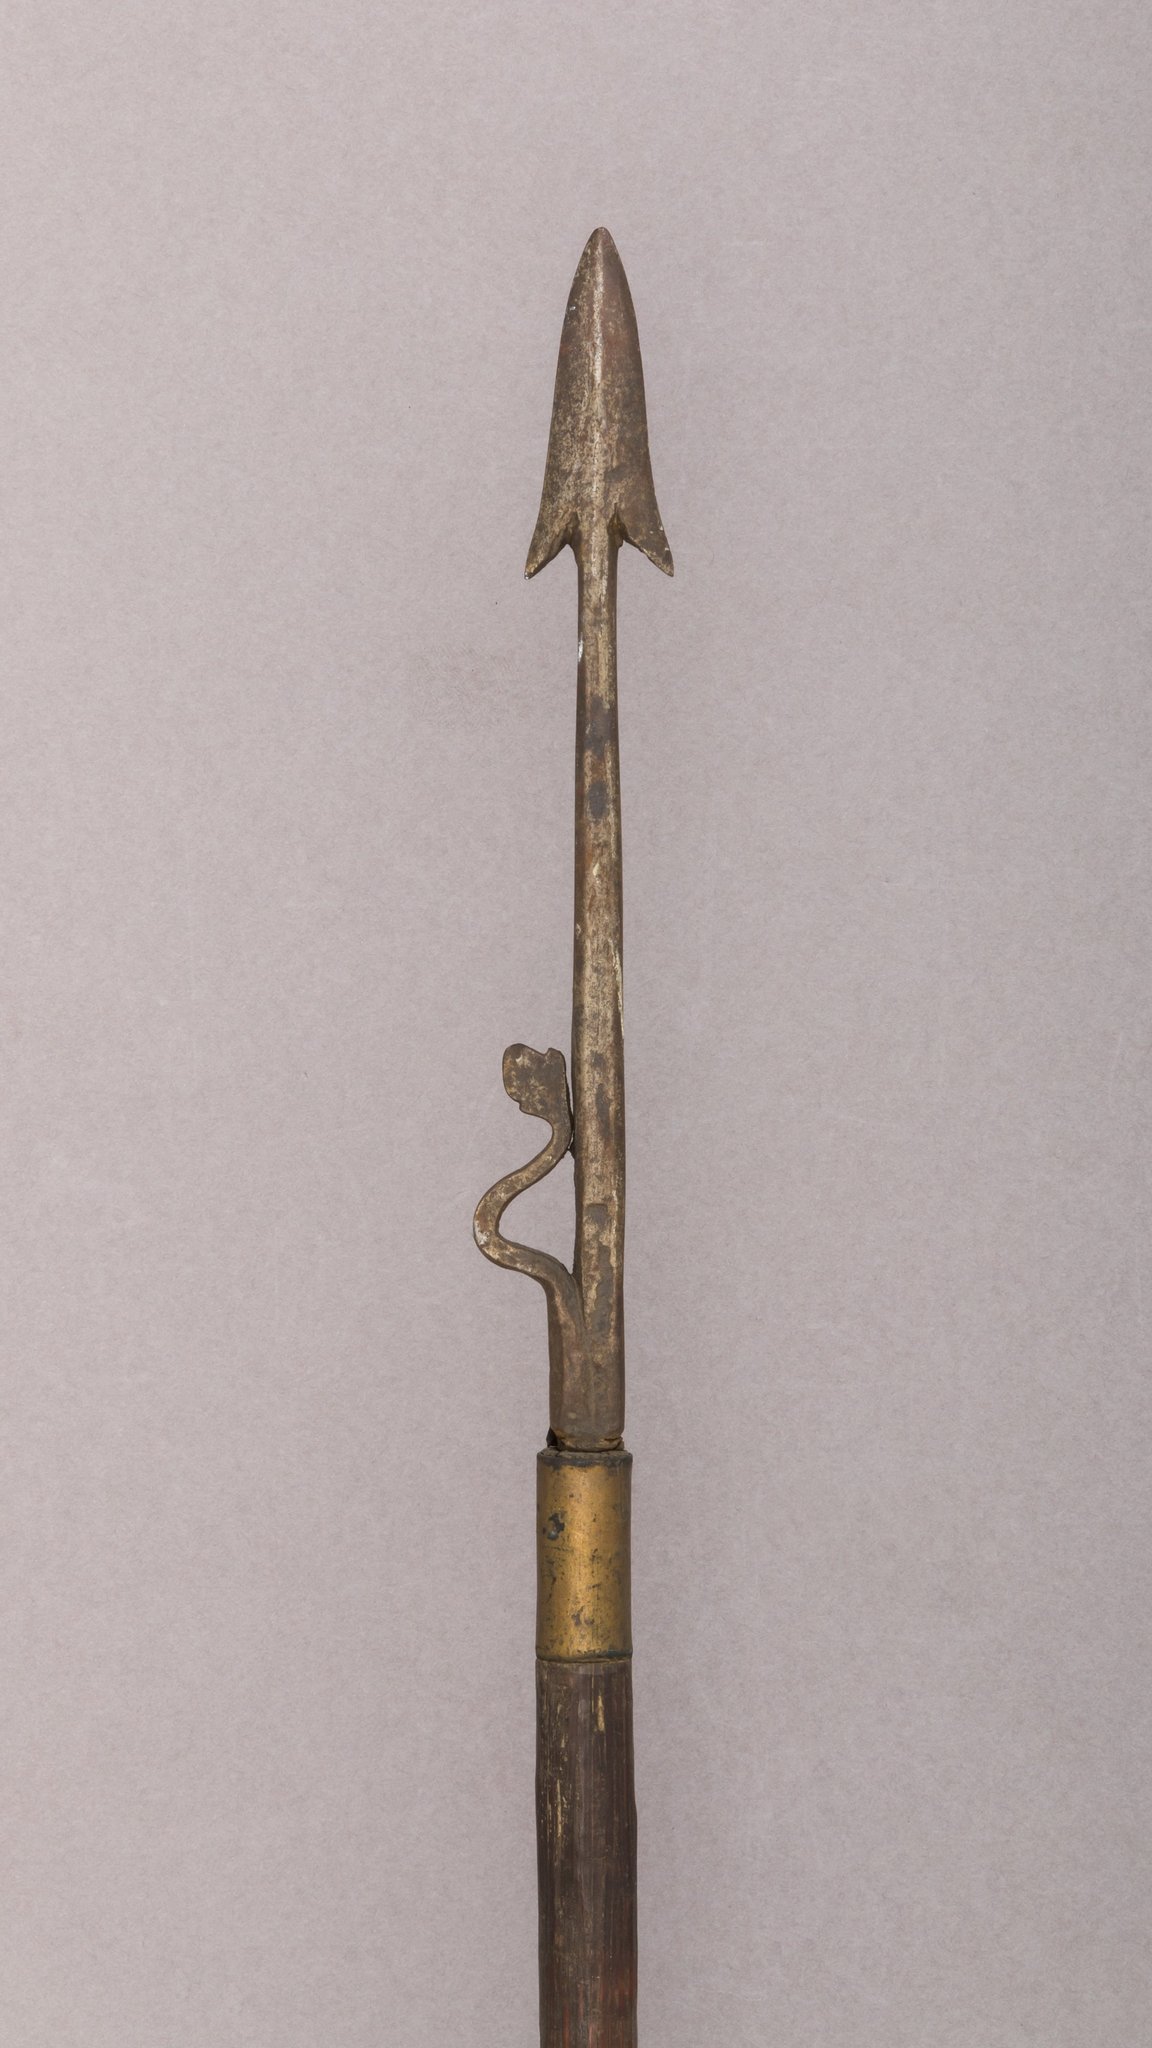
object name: spear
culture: madurese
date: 1701-1900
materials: copper, hair, steel, wood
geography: indonesia